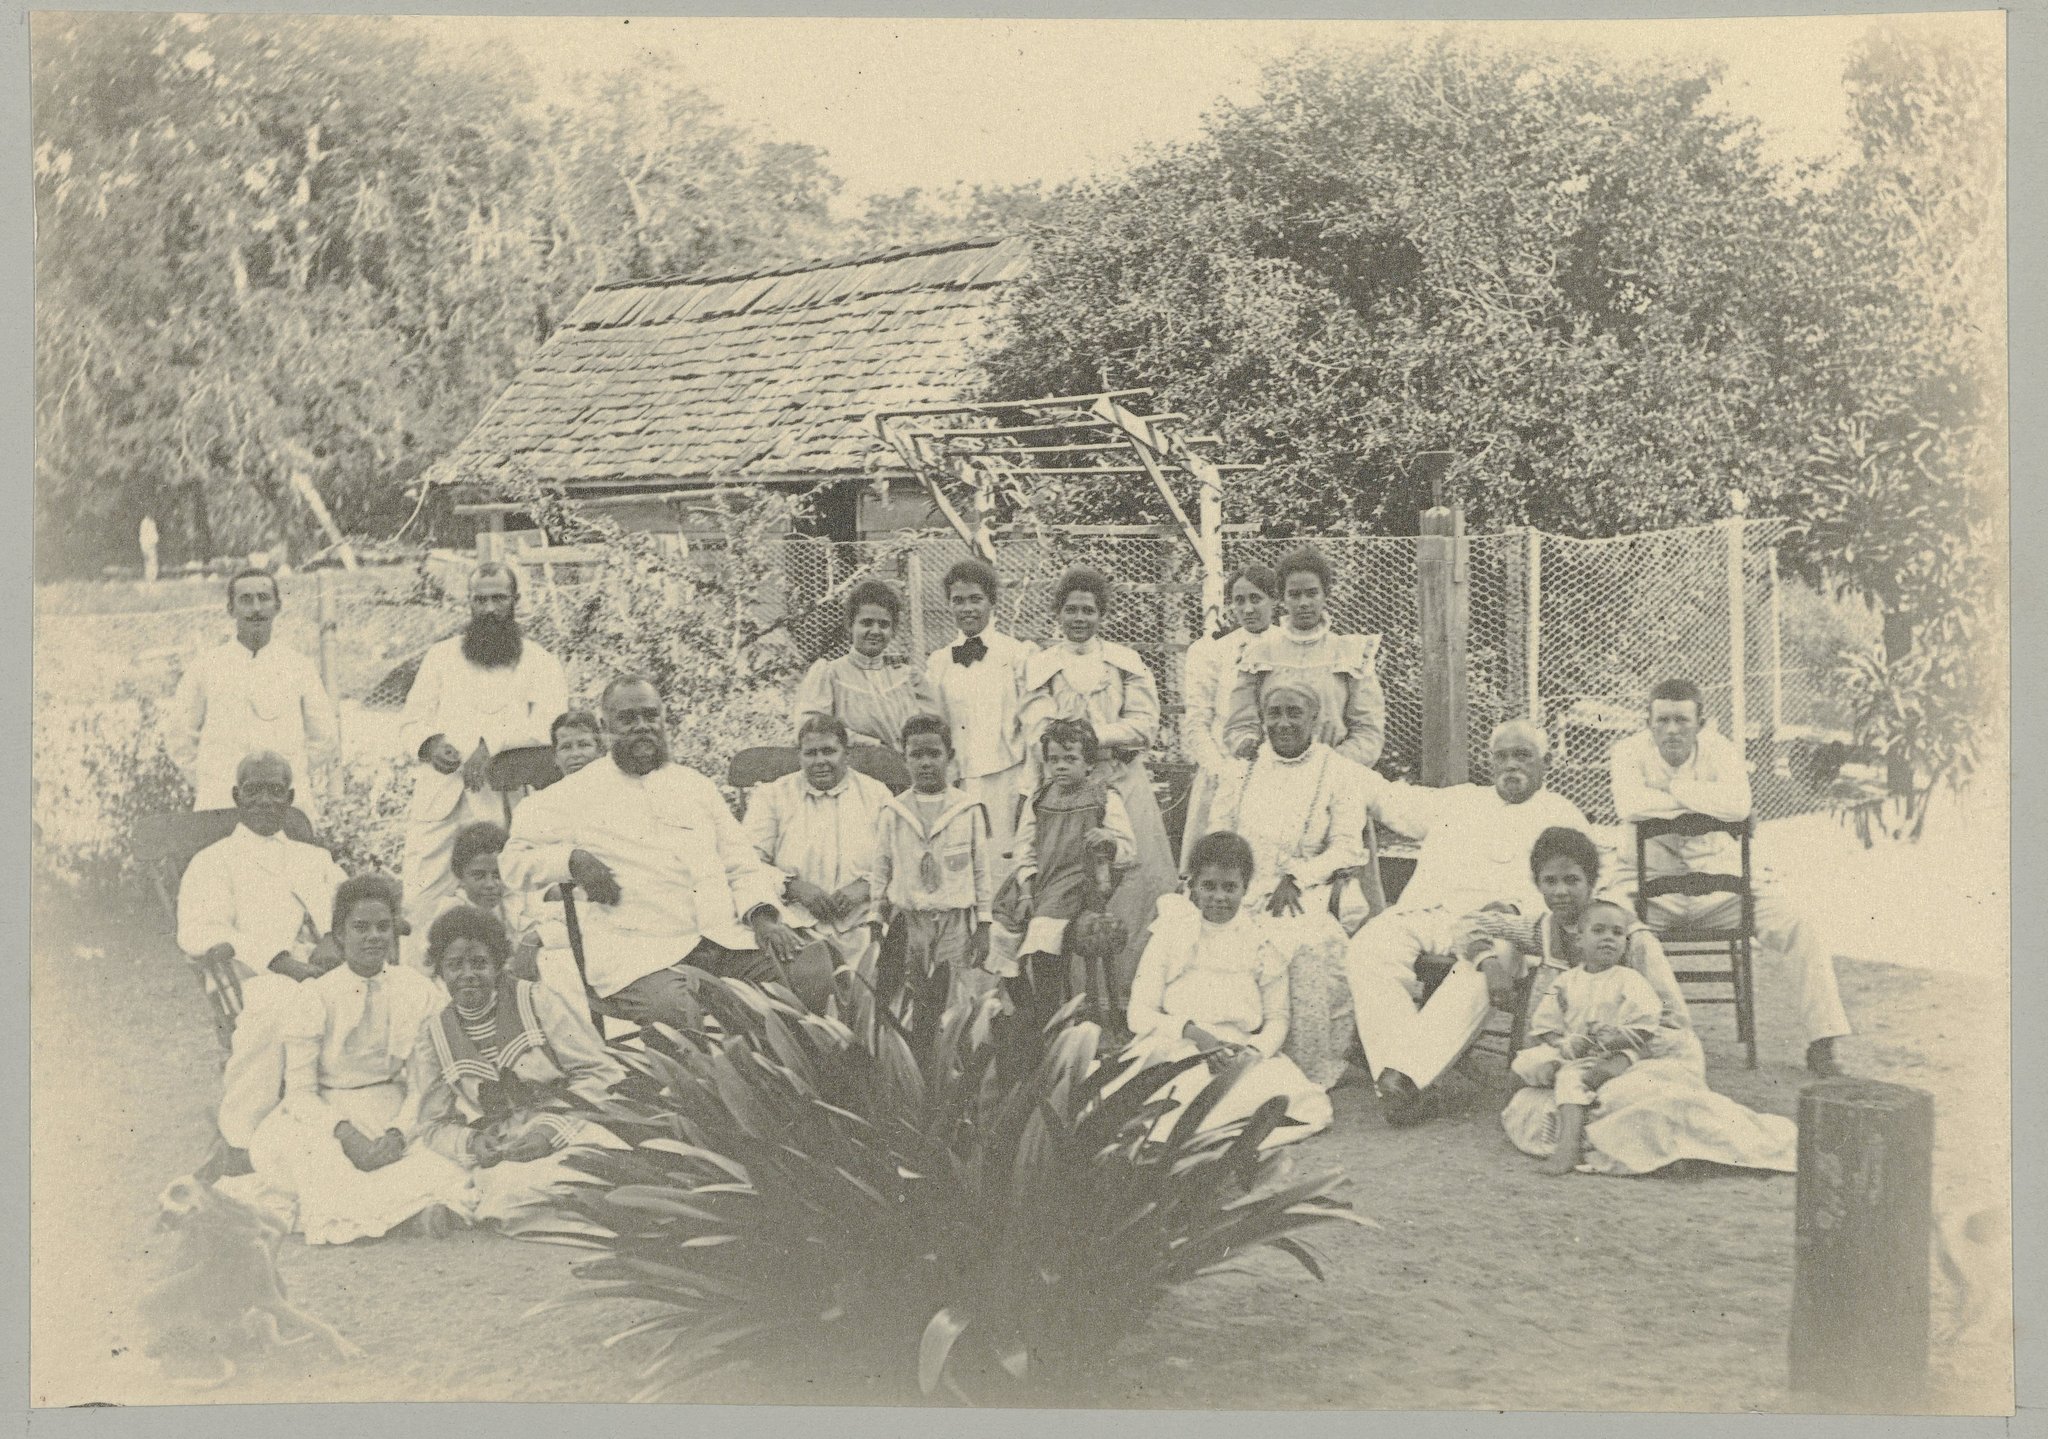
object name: photograph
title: Groepsportret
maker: moellaert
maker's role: fotograaf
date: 1906-1913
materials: photographic support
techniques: collodion silver print, gelatin silver print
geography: suriname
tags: suriname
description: Groepsfoto van een onbekende familie of groep. Onderdeel van het fotoalbum Souvenir de Voyage (deel 4), over het leven van de familie Dooyer in en rond de plantage Ma Retraite in Suriname in de jaren 1906-1913.